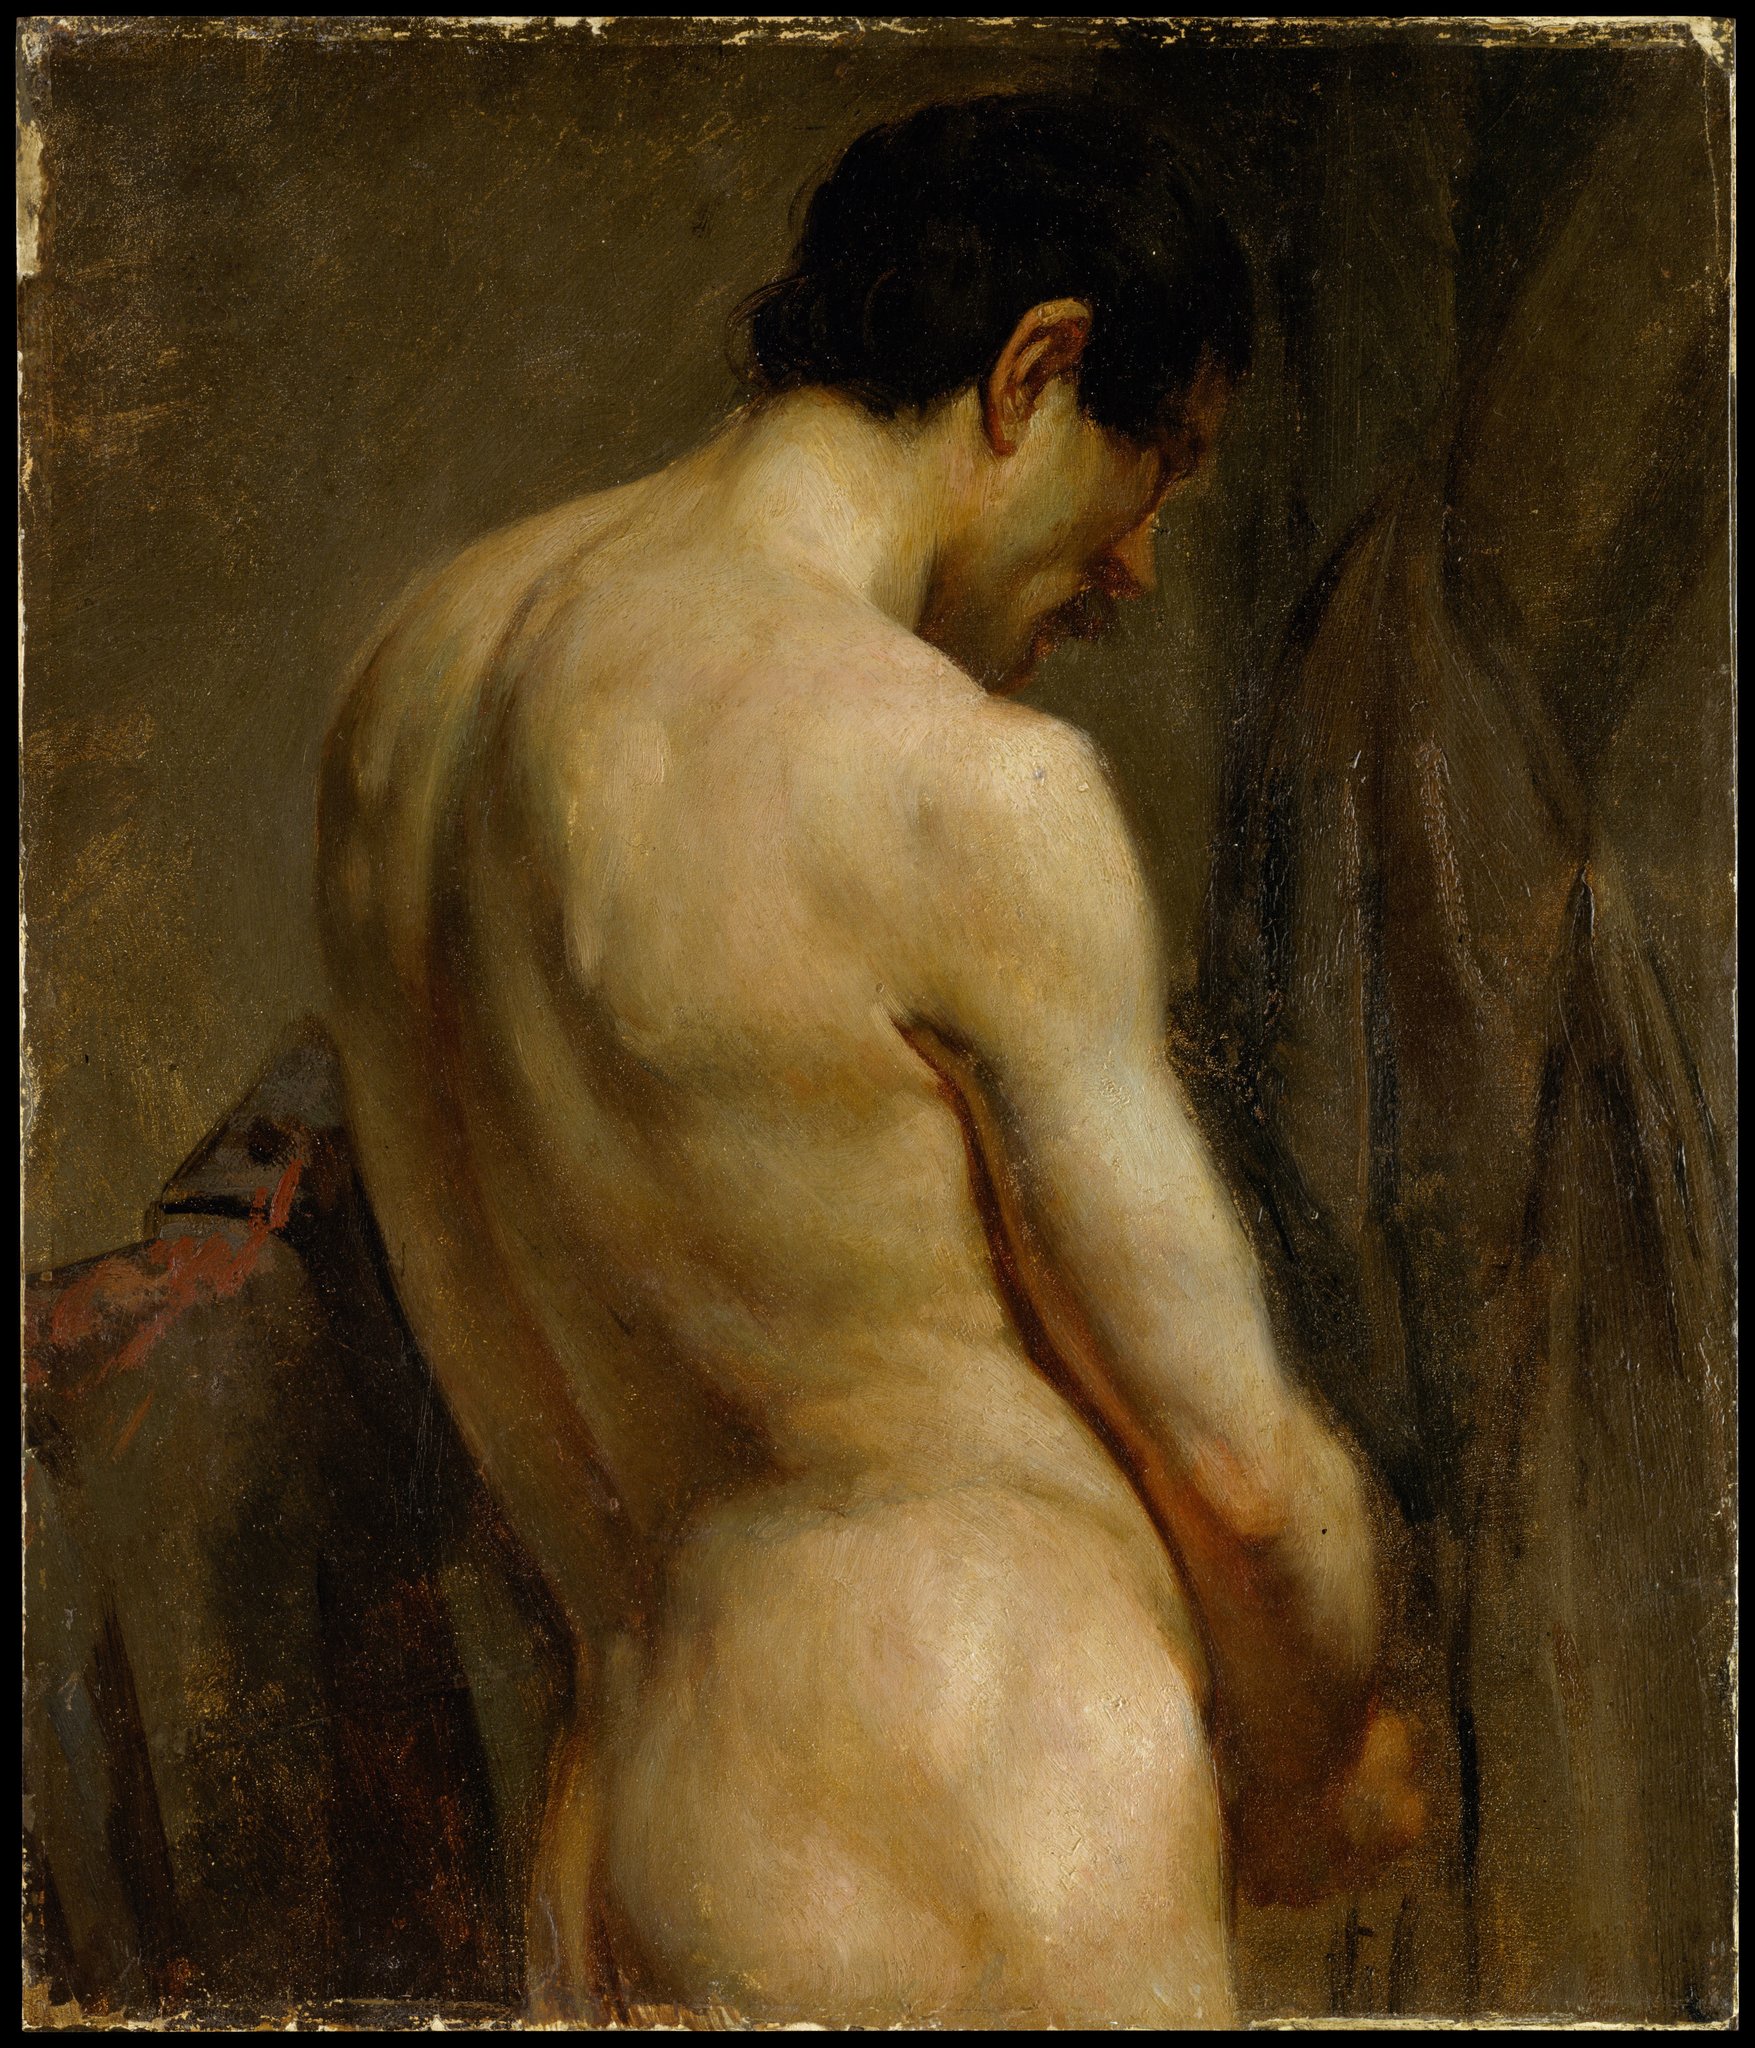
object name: painting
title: Male Academy Figure: Half-Length, Side View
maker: eugène delacroix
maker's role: artist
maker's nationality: french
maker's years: 1798-1863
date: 1818-1820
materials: oil, panel, paper